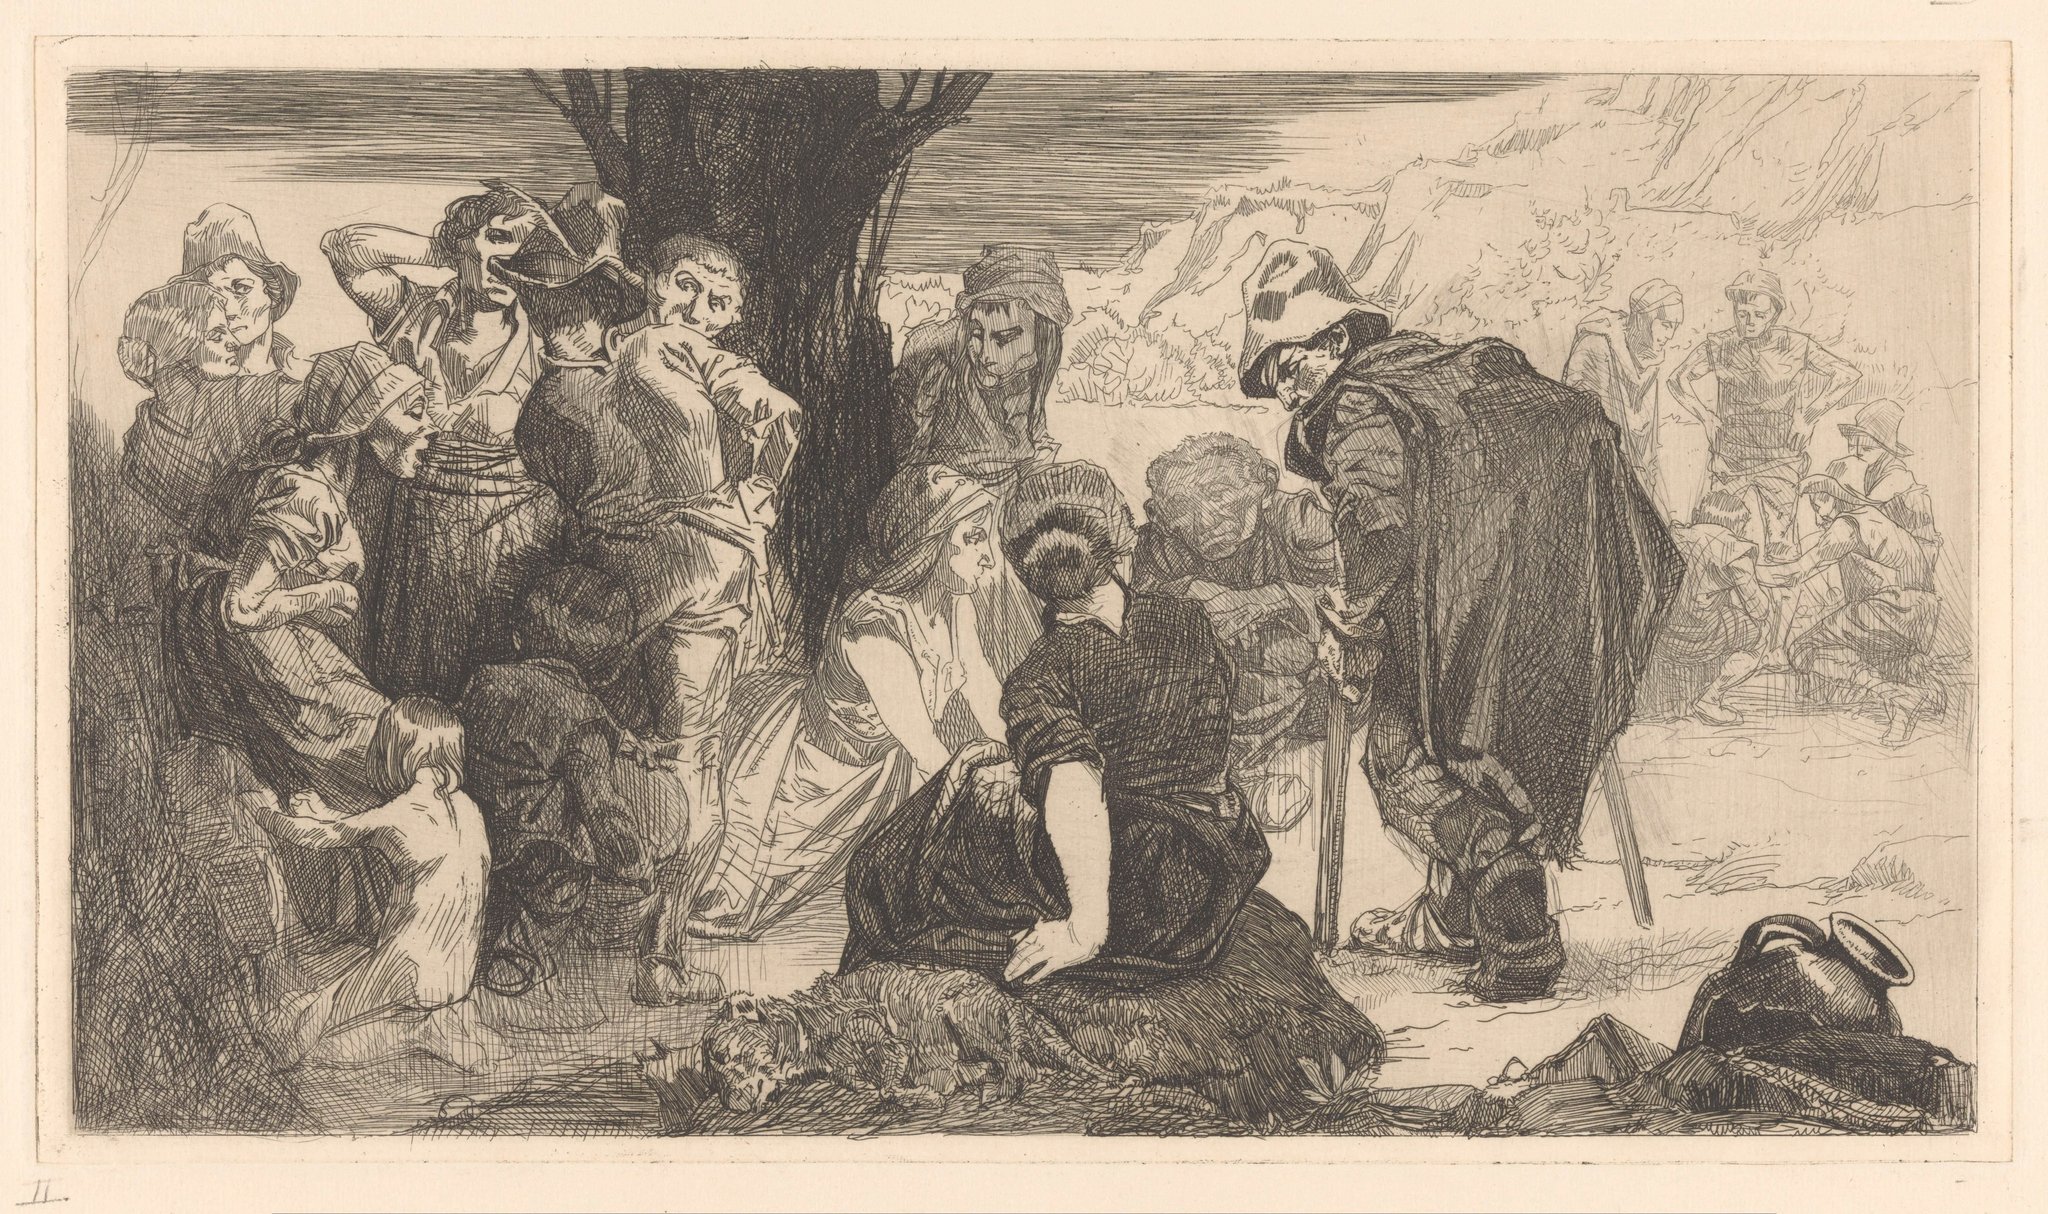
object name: print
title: Zigeuners en landlopers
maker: johannes josephus aarts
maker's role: draughtsman, print maker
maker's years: 1871-1934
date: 1881-1934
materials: paper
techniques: etching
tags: crutches, wandering communities: romani or roma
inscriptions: watermark, collector's mark: Lugt 2228, collector's mark: Lugt 2166, collector's mark: Lugt 2760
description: Een groep mannen, vrouwen en kinderen, waarschijnlijk landlopers, houdt zich op bij een boom. Rechts op de voorgrond loopt een man met twee krukken. Achter de groep een open landschap, dat begrensd wordt door heuvels.